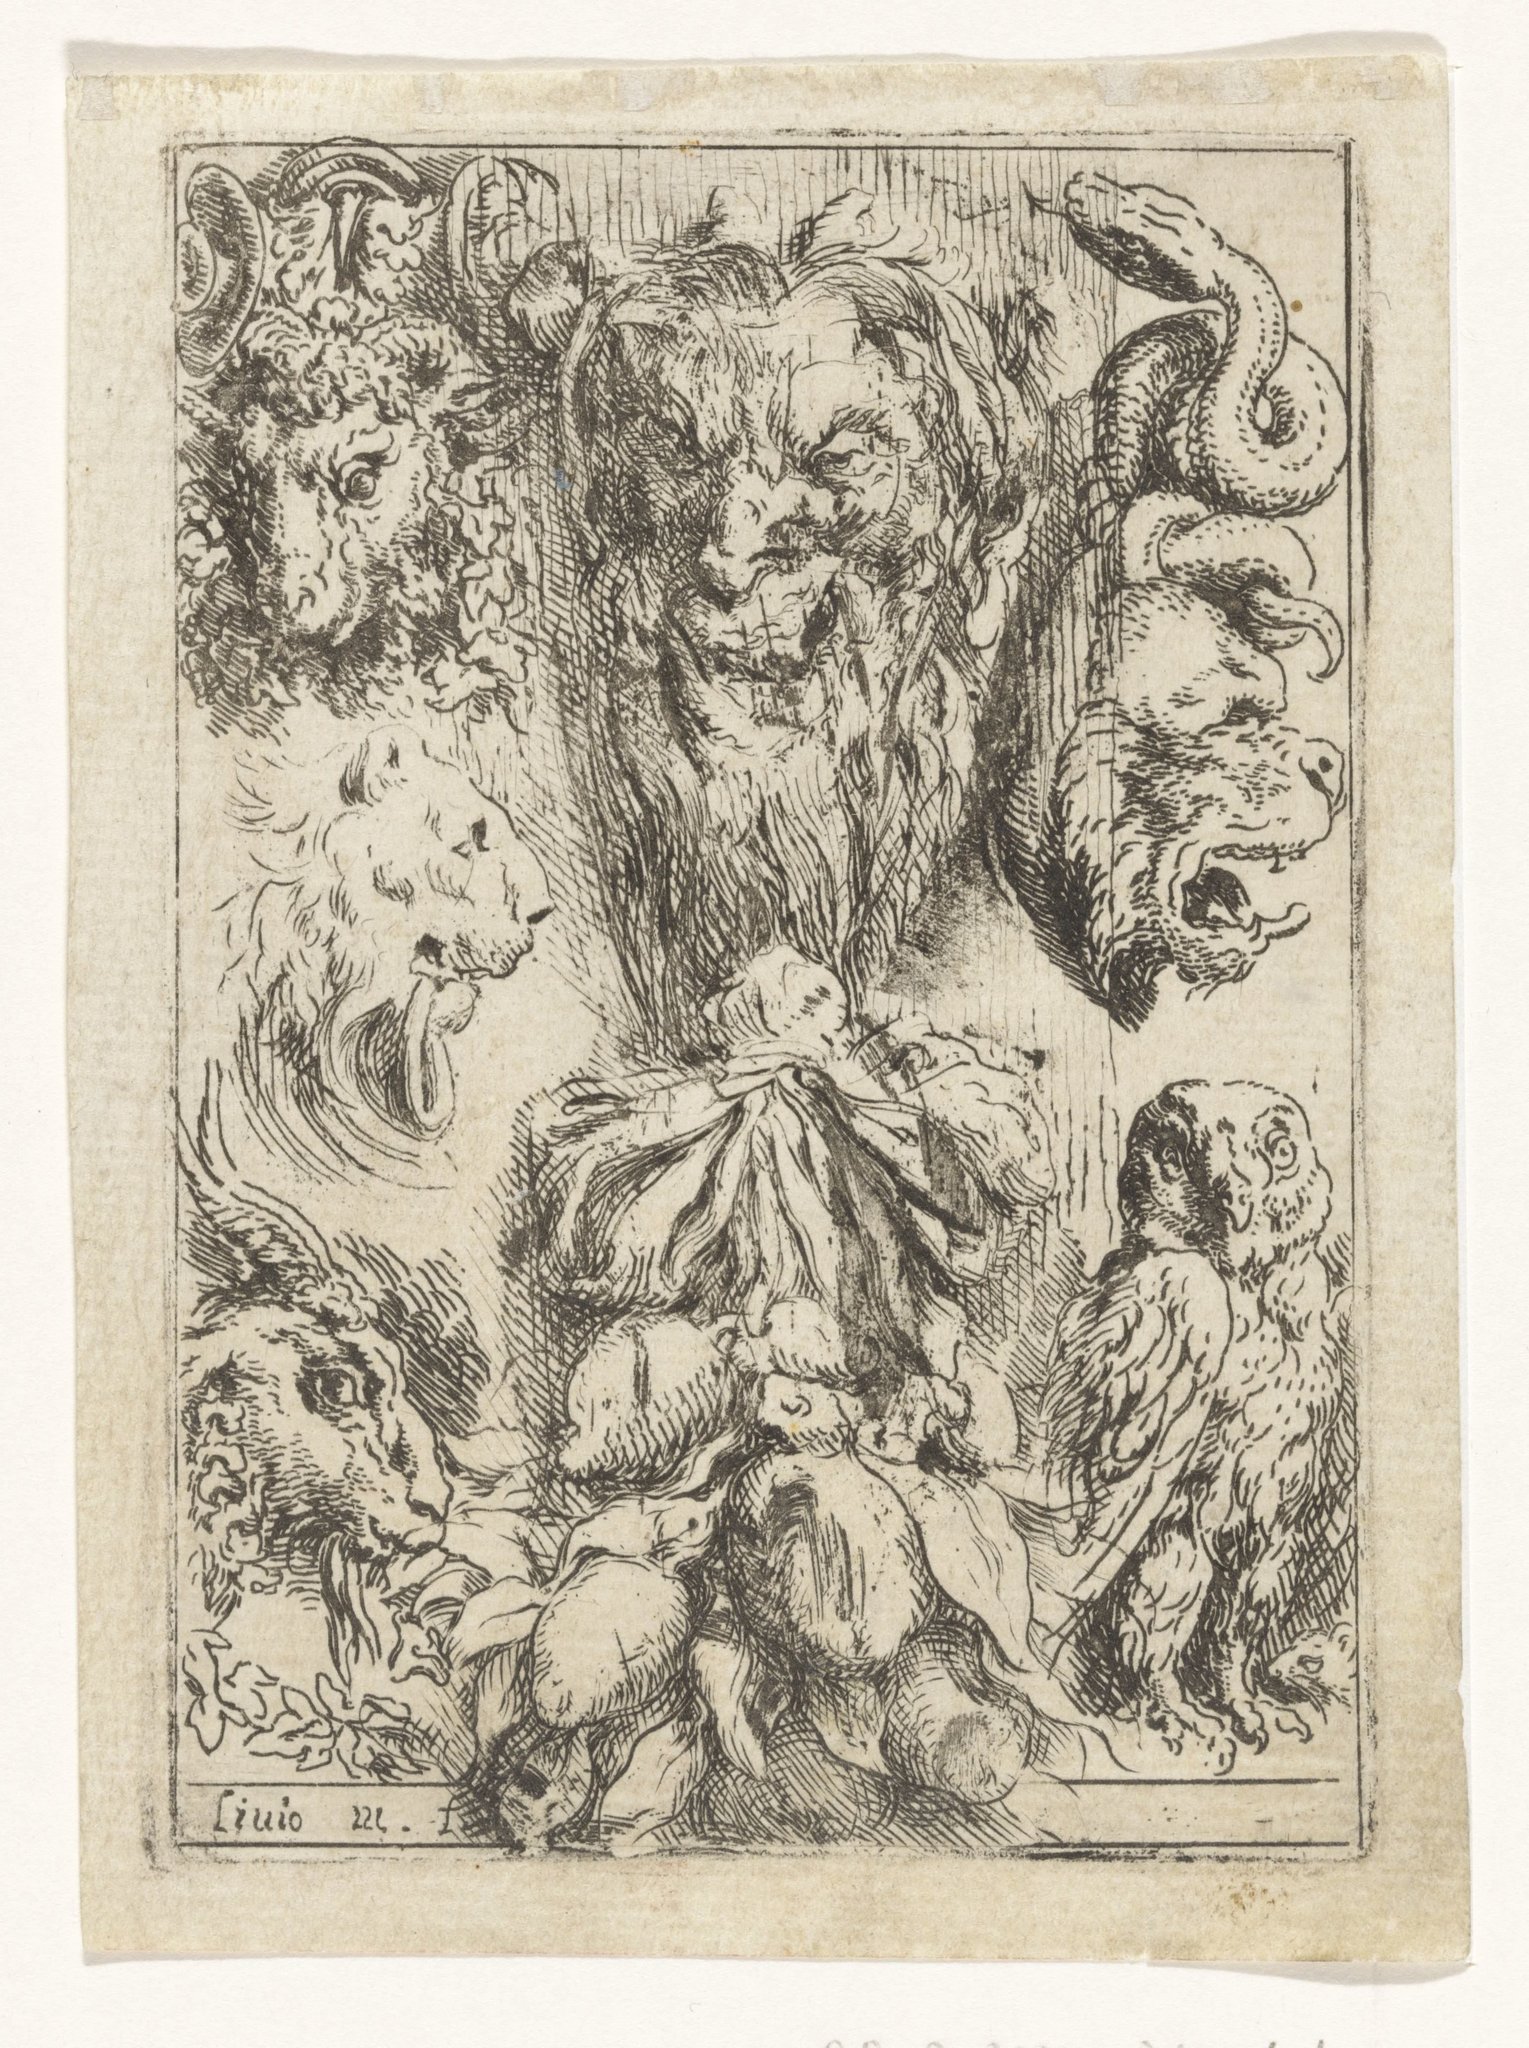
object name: ornament print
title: Divertimenti di Livio Meus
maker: lieven mehus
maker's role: draughtsman, print maker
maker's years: 1630-1691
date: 1650-1671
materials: paper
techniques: etching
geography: low countries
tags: ornaments ~ art, groups of animals (+ head of an animal), fruits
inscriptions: collector's mark: Lugt 2760, collector's mark: Lugt 2228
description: Onderdeel serie van vijf ornamentprenten met titelblad.